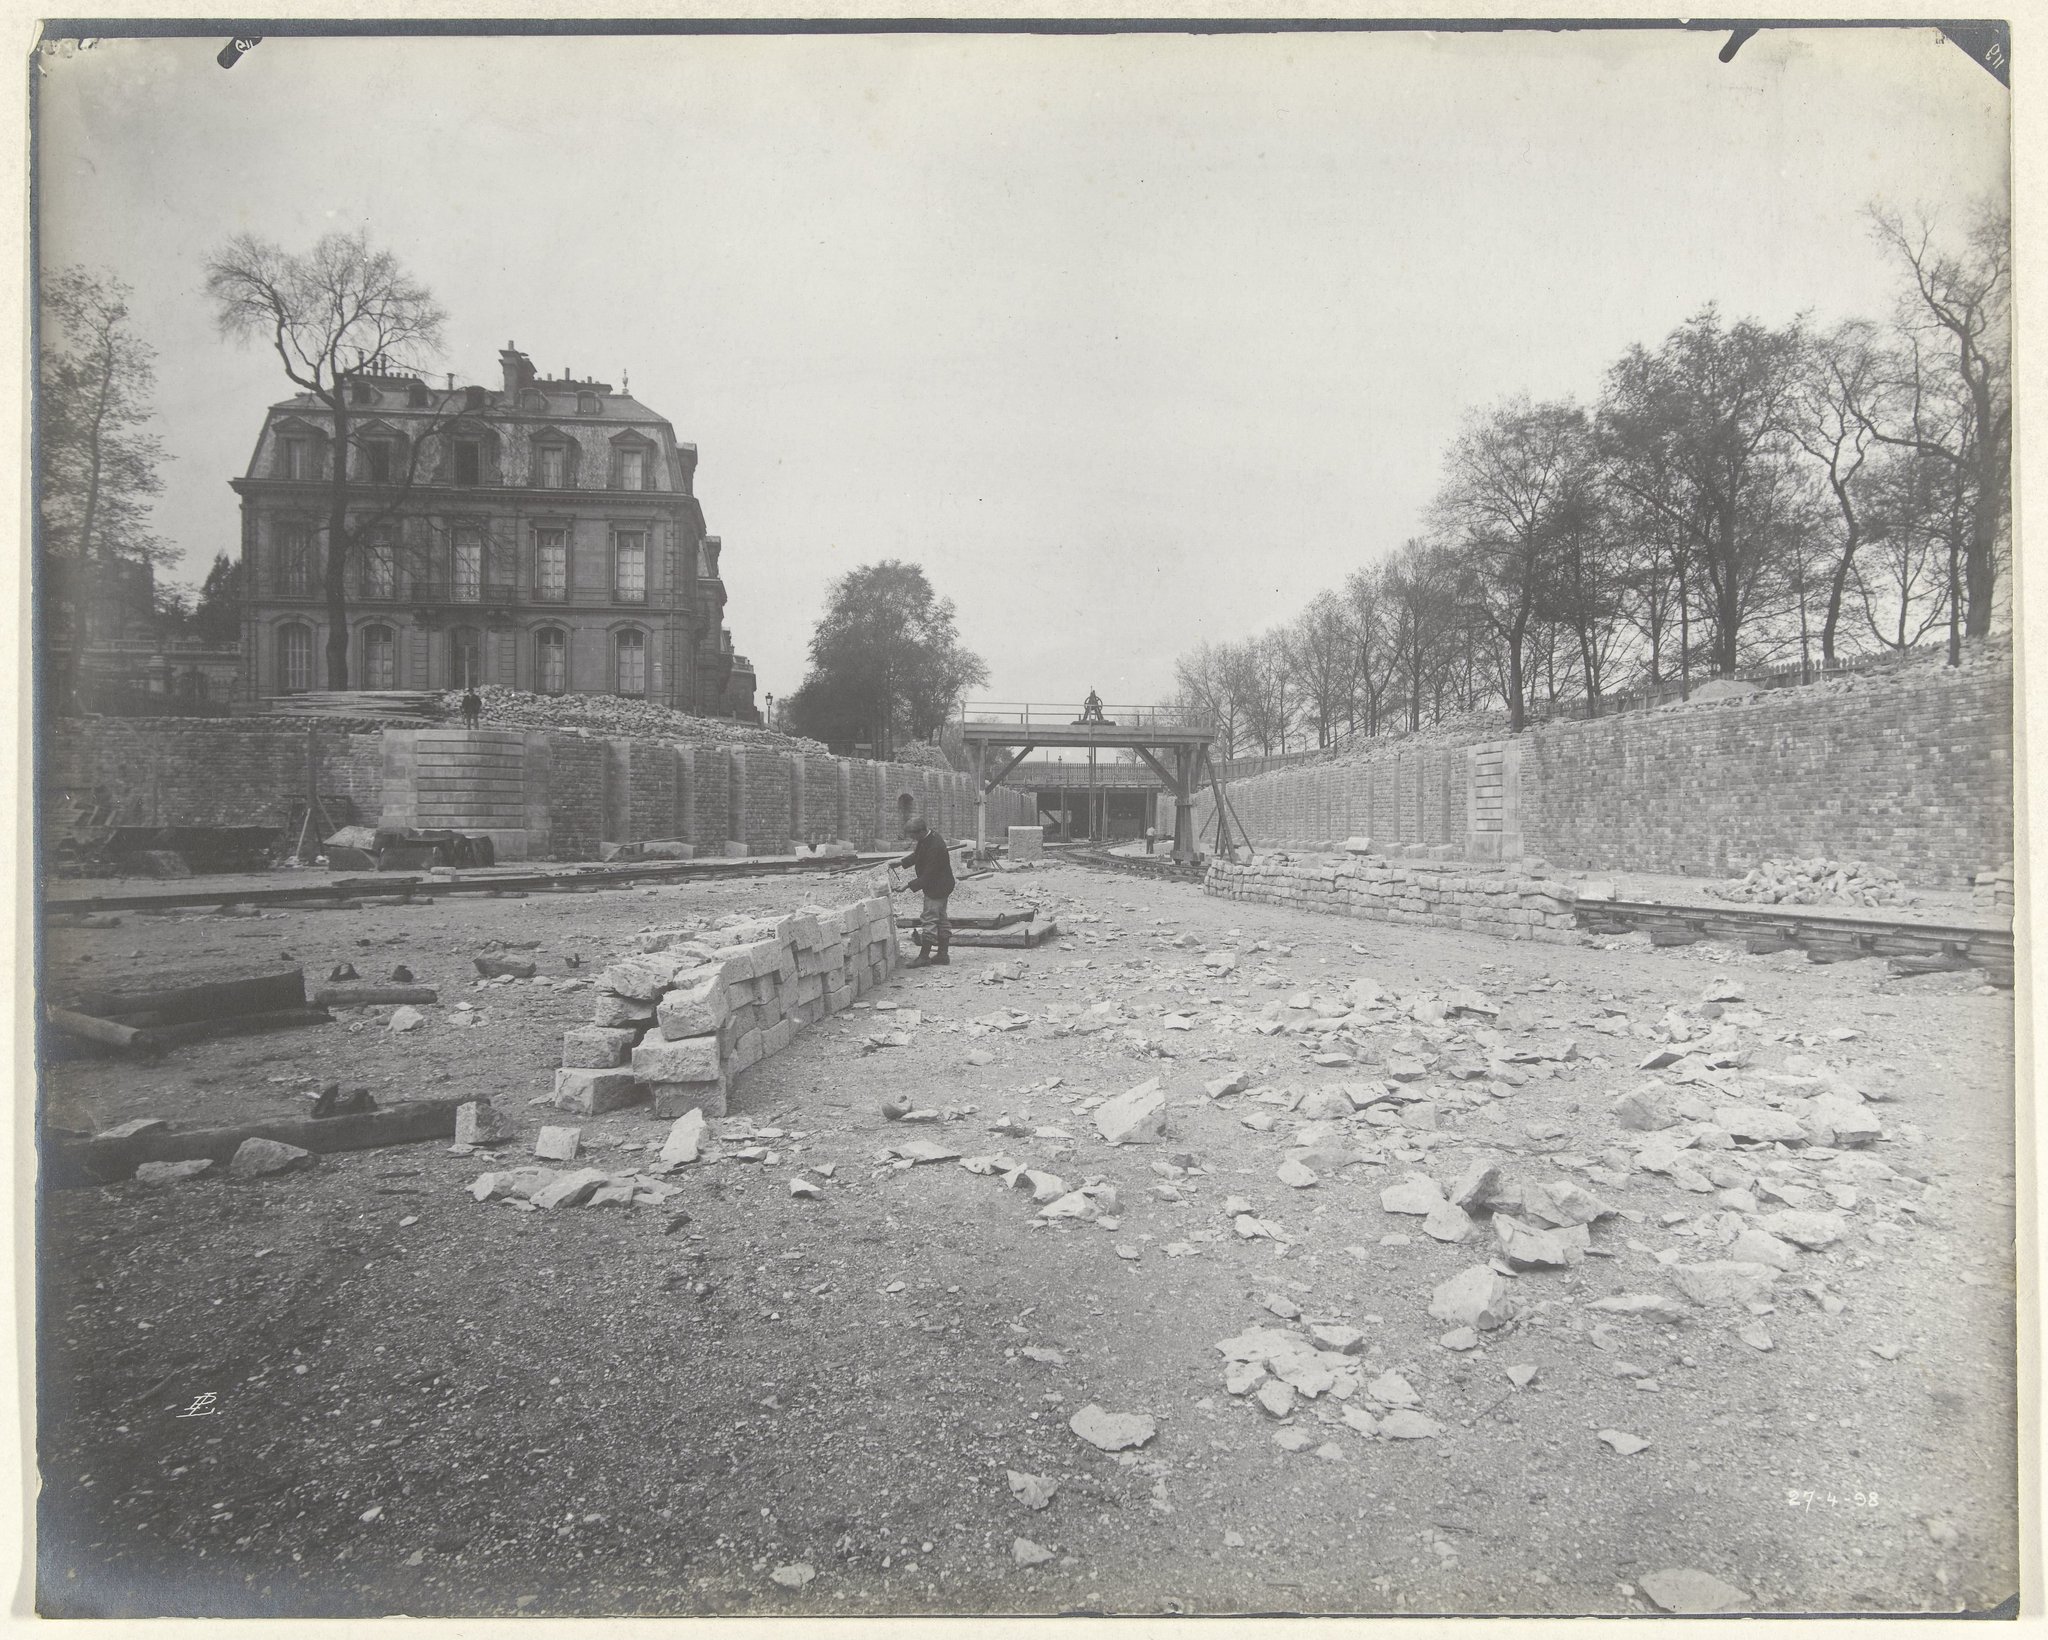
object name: photograph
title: Aanleg van de metro in Parijs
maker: emmanuel l. pottier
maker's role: fotograaf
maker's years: 1864-1921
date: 1898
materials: paper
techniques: gelatin silver print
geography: paris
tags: underground railway, 'métro', building-site, paris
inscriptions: date: ‘9-7-98’, number: ‘191’, monogram: ‘L.P.’